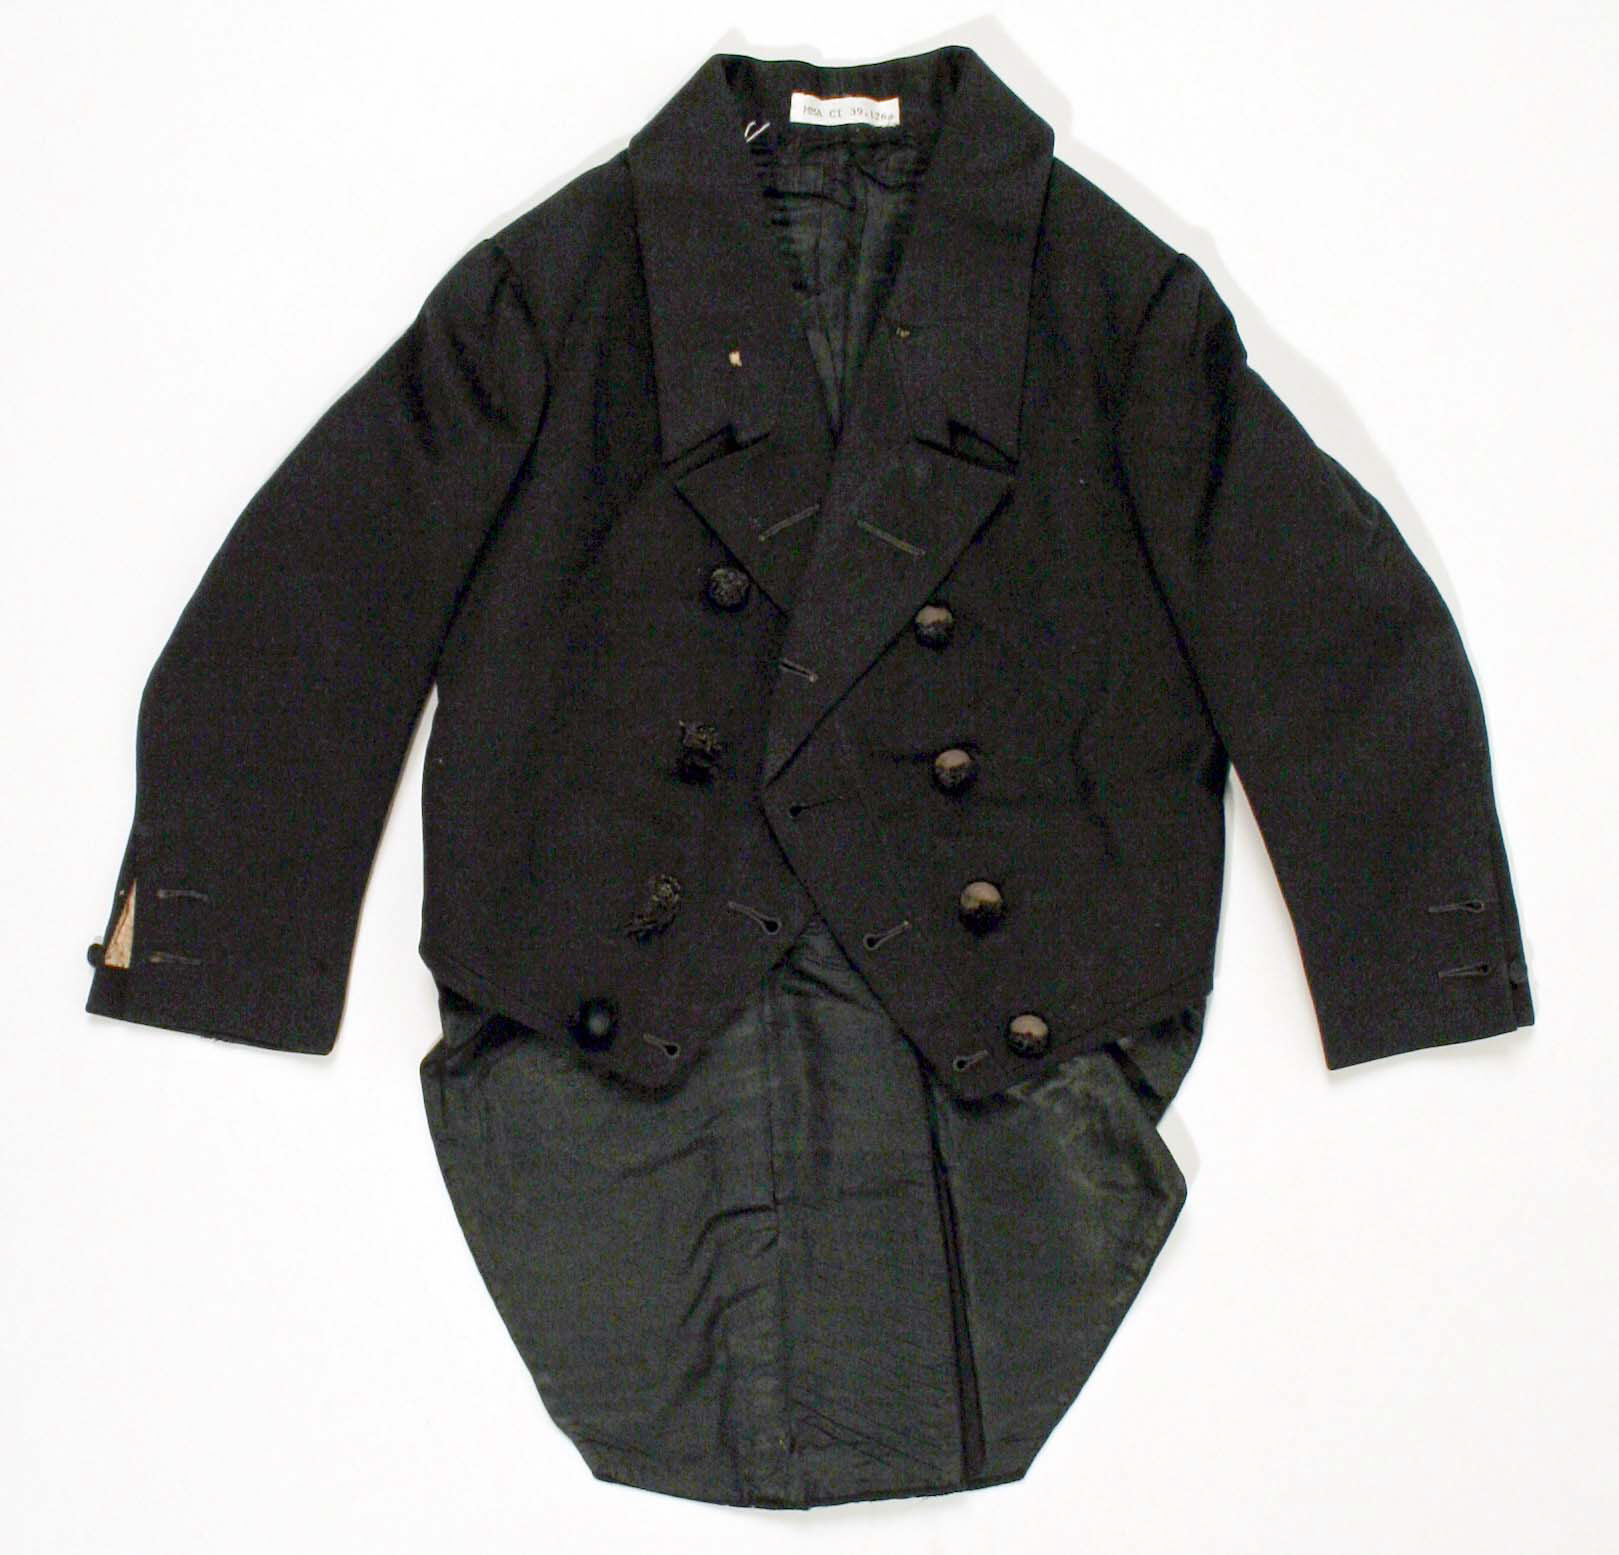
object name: evening suit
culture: american or european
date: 1857